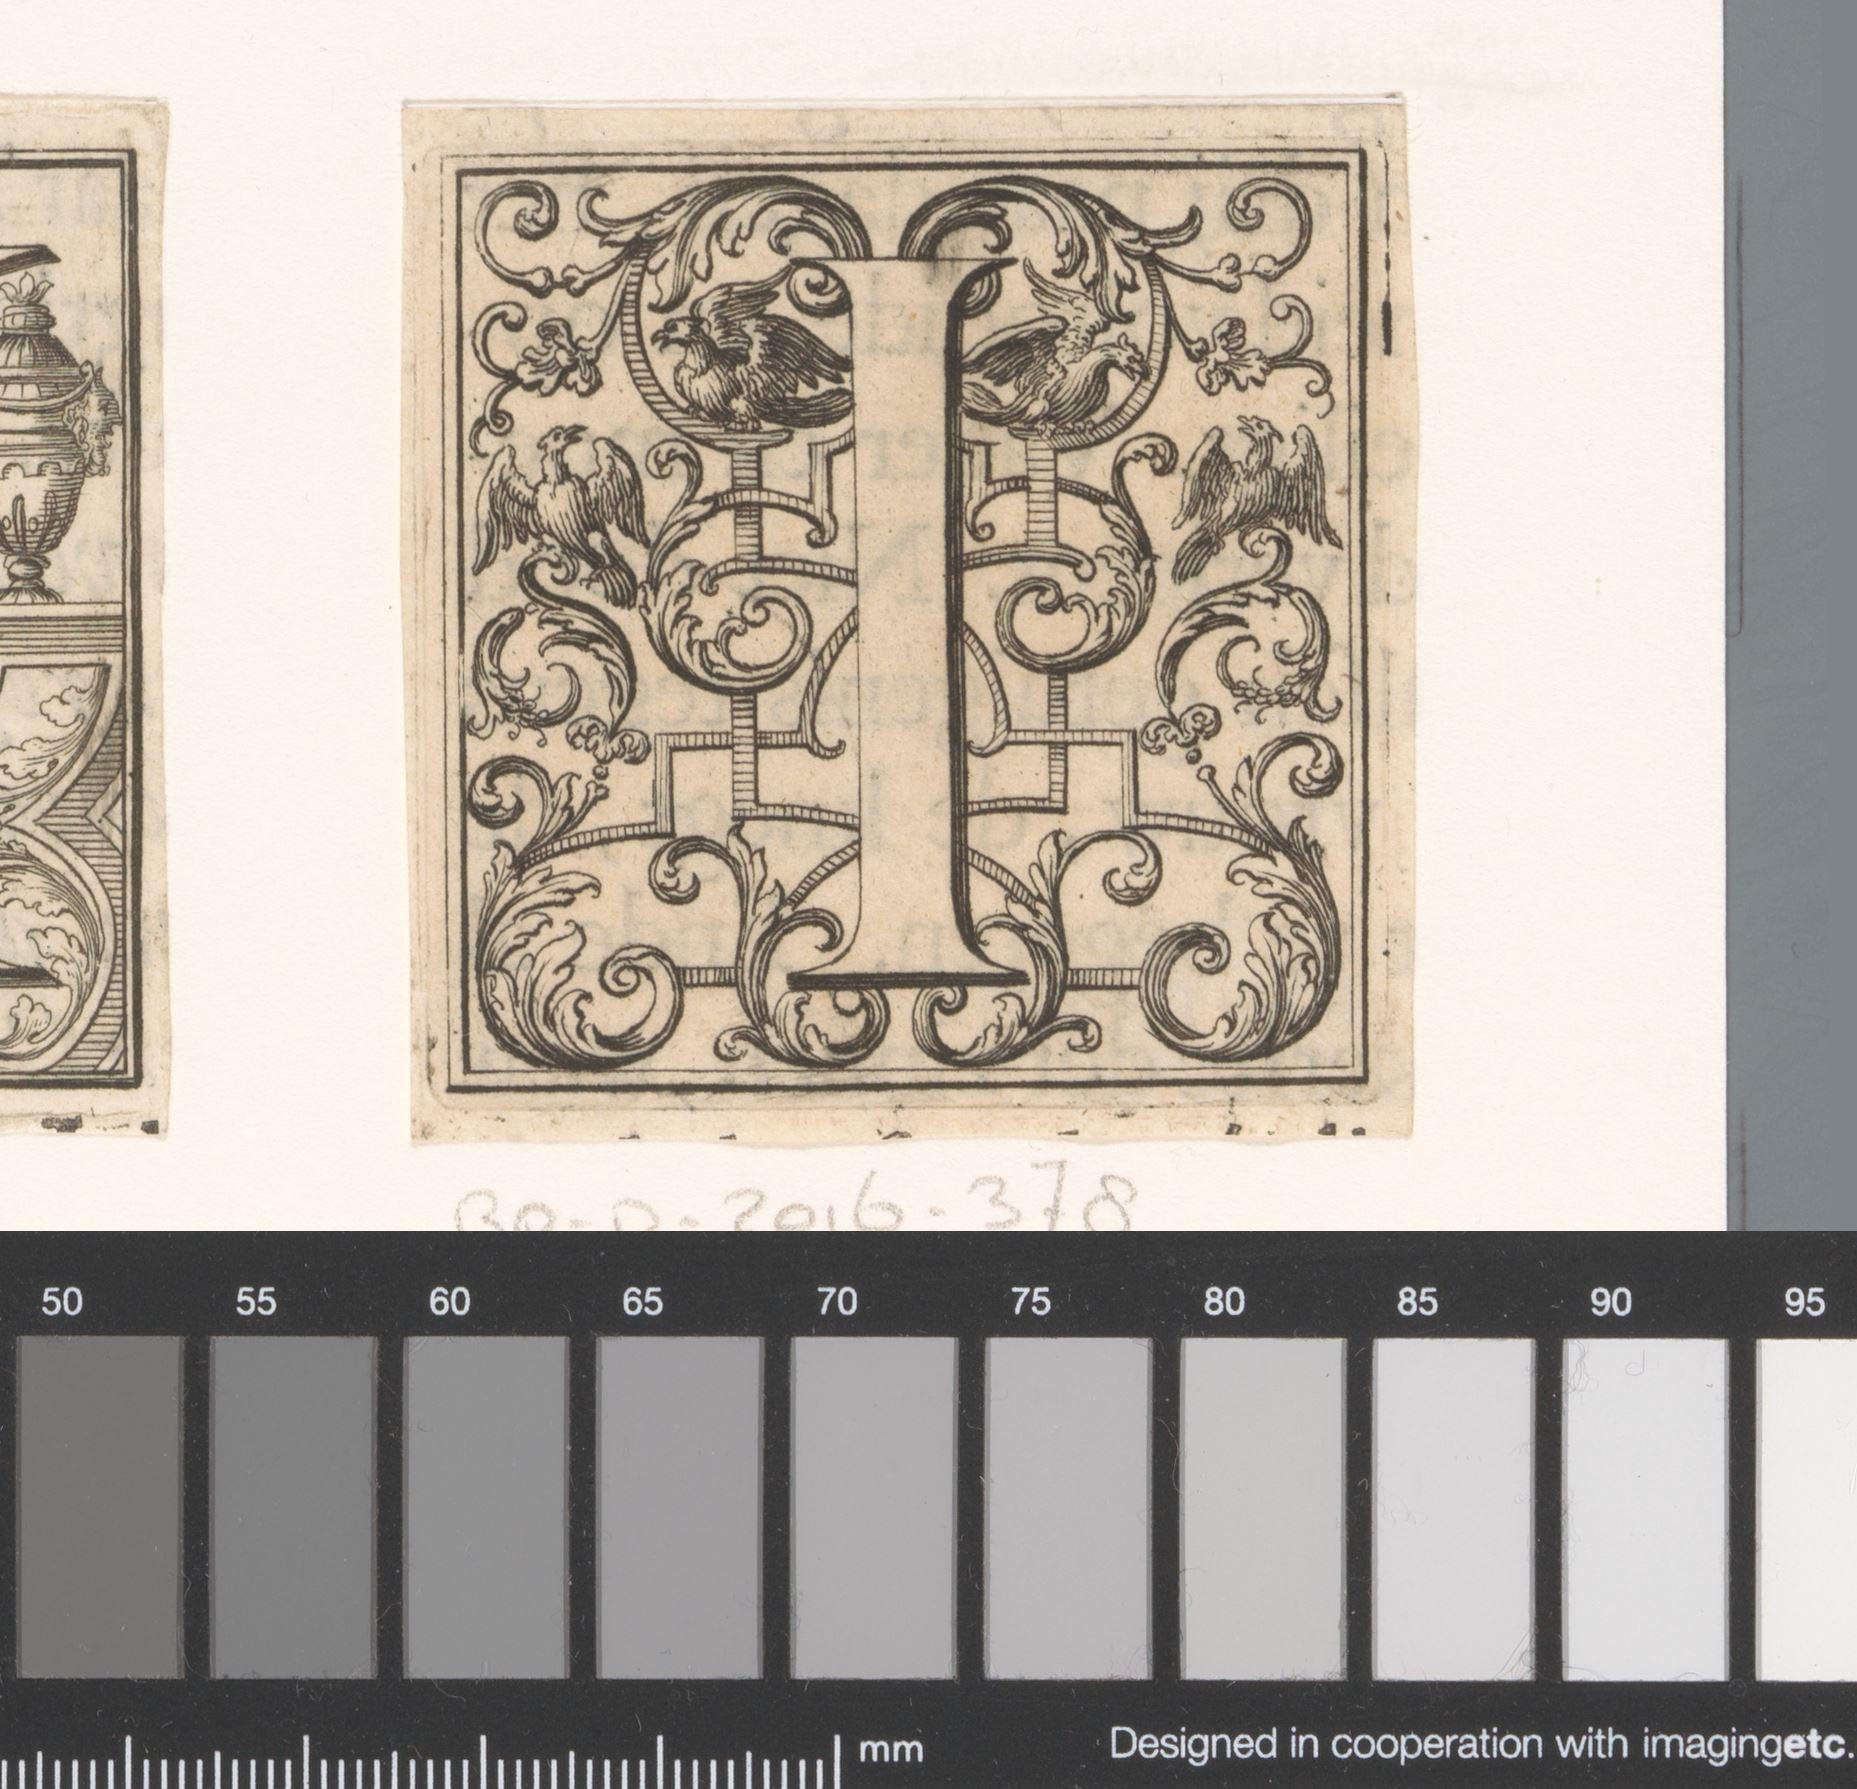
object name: ornament print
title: Letter I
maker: Anonymous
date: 1700-1799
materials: paper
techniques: etching, letterpress printing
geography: netherlands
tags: fancy letters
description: Letter I tegen een achtergrond met vlechtwerk en vogels.